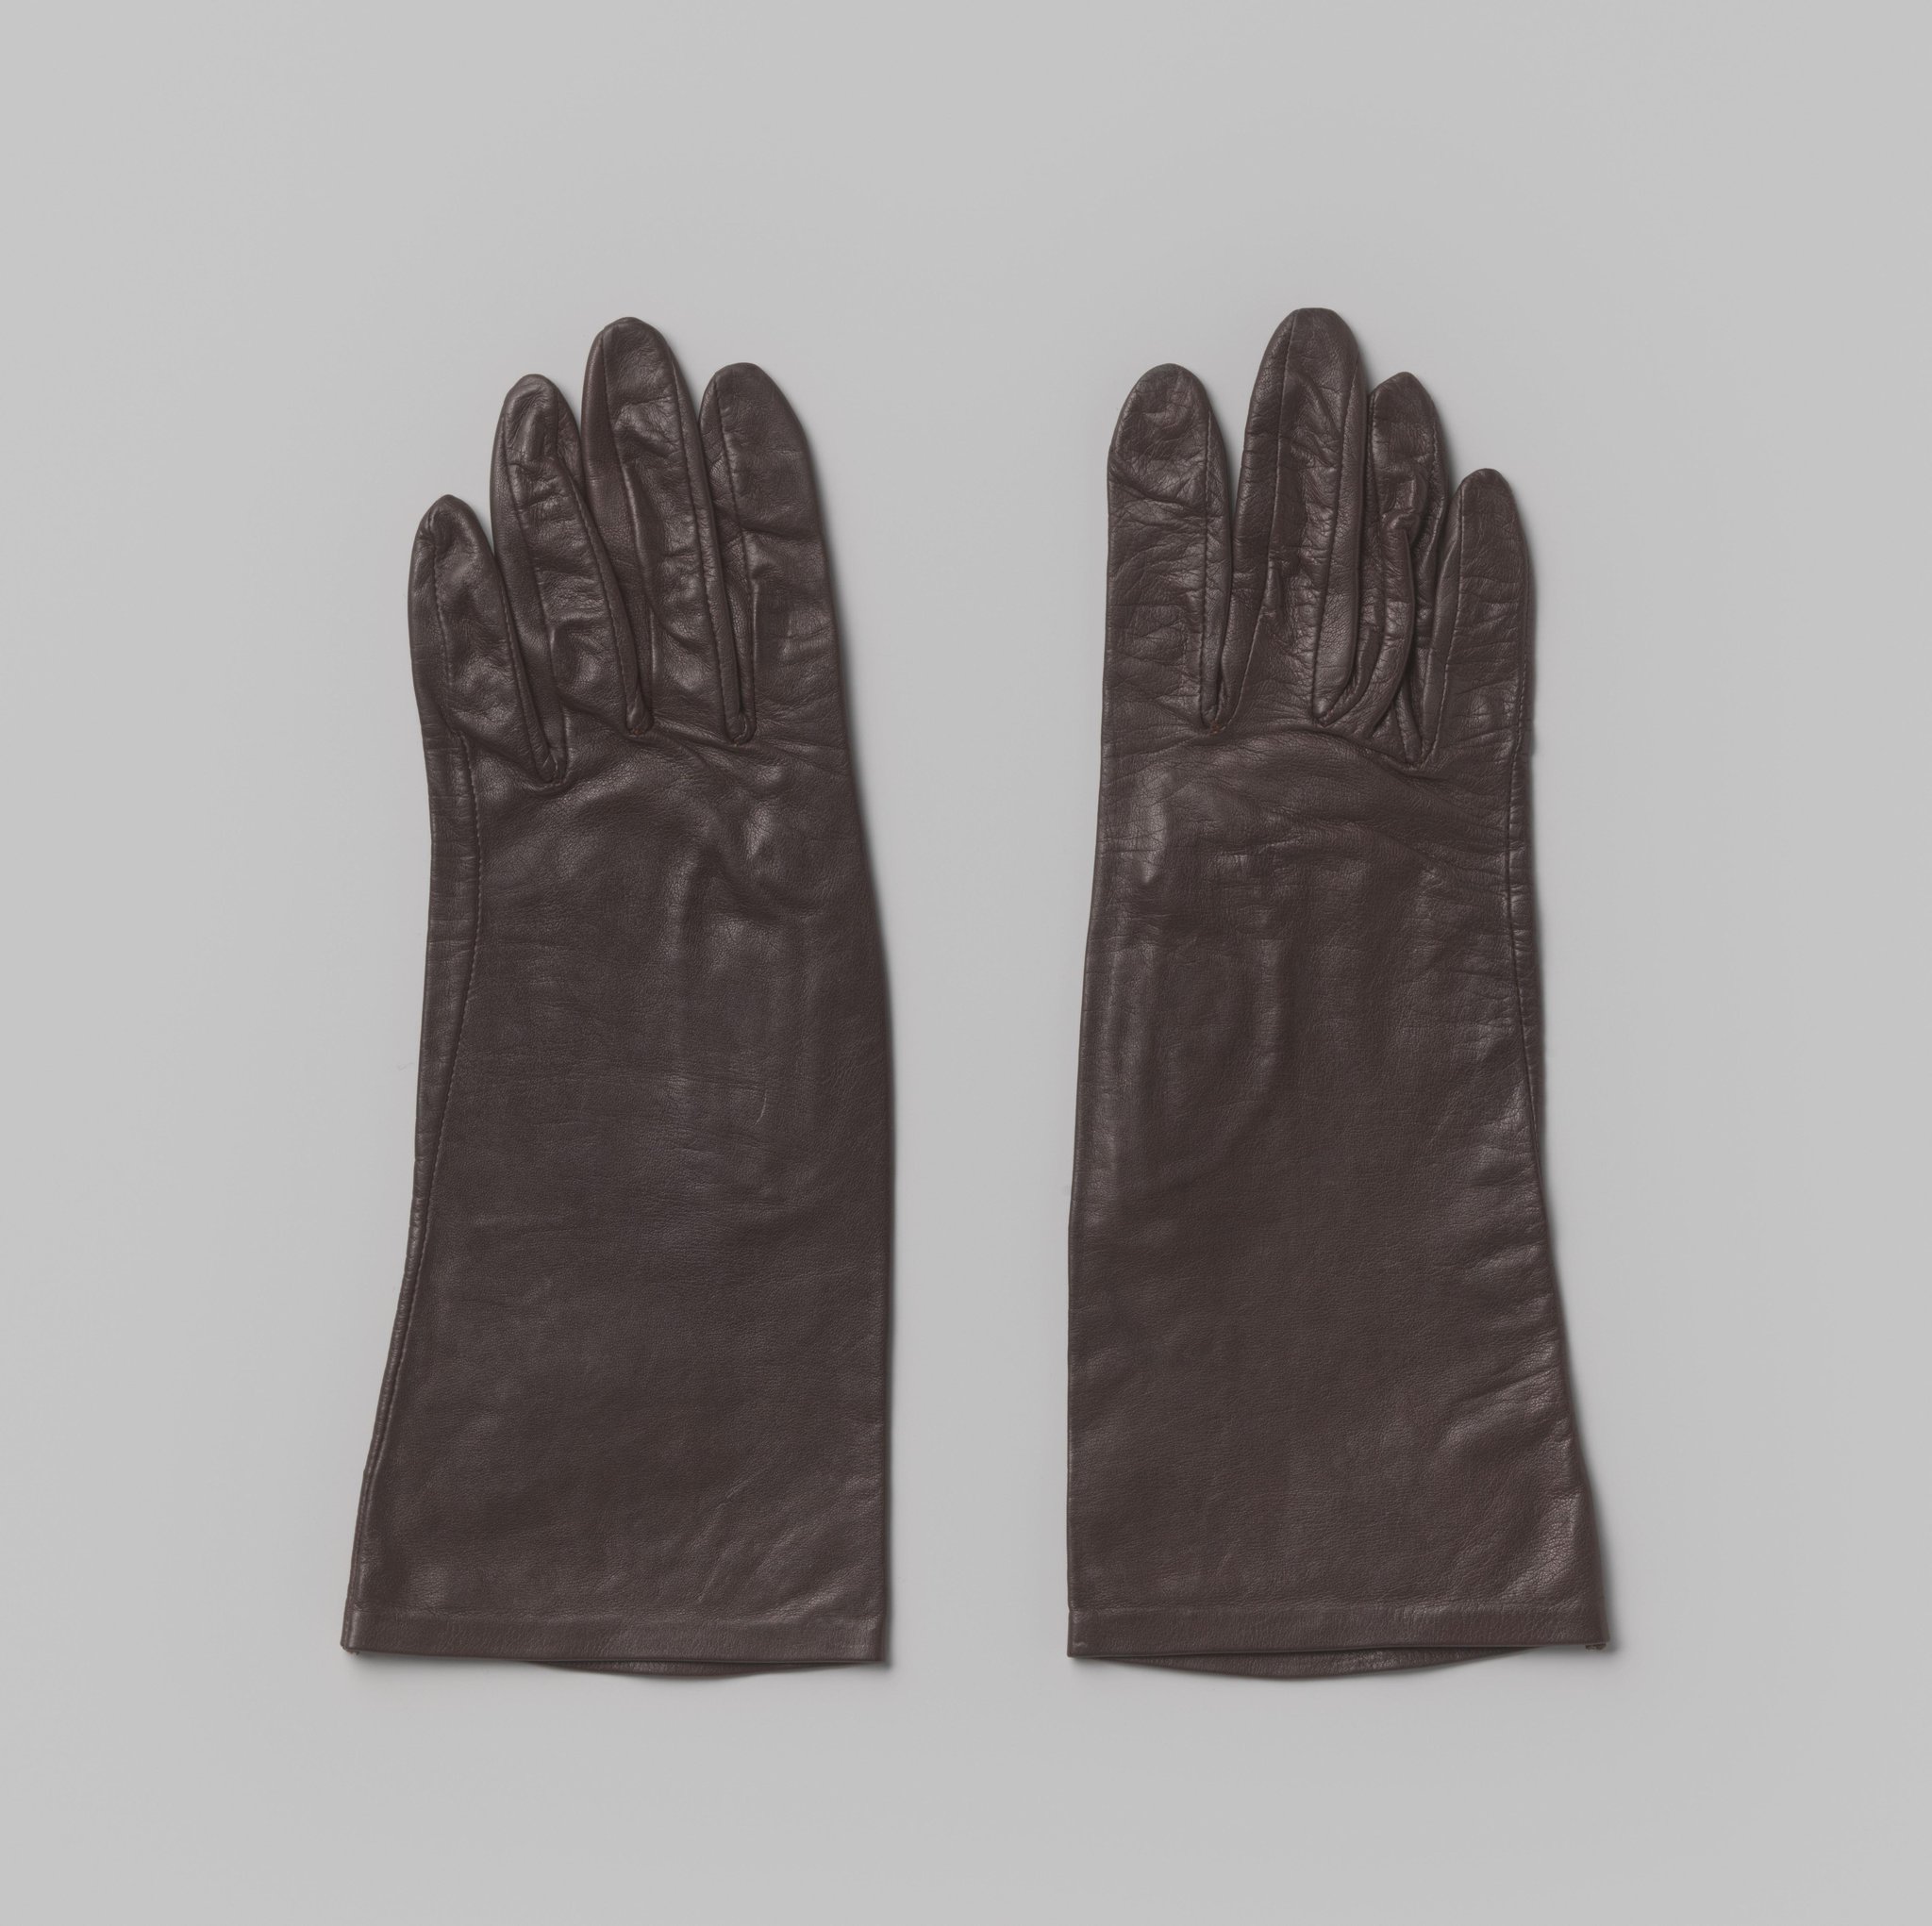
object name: glove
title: Handschoen, van een paar, van donkerbruin glacéleer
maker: Anonymous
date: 1960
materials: leather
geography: amsterdam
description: Rechter handschoen, van bruin glacéleer. Model: kort, met omgezoomde entree. Geen versieringsnaden.